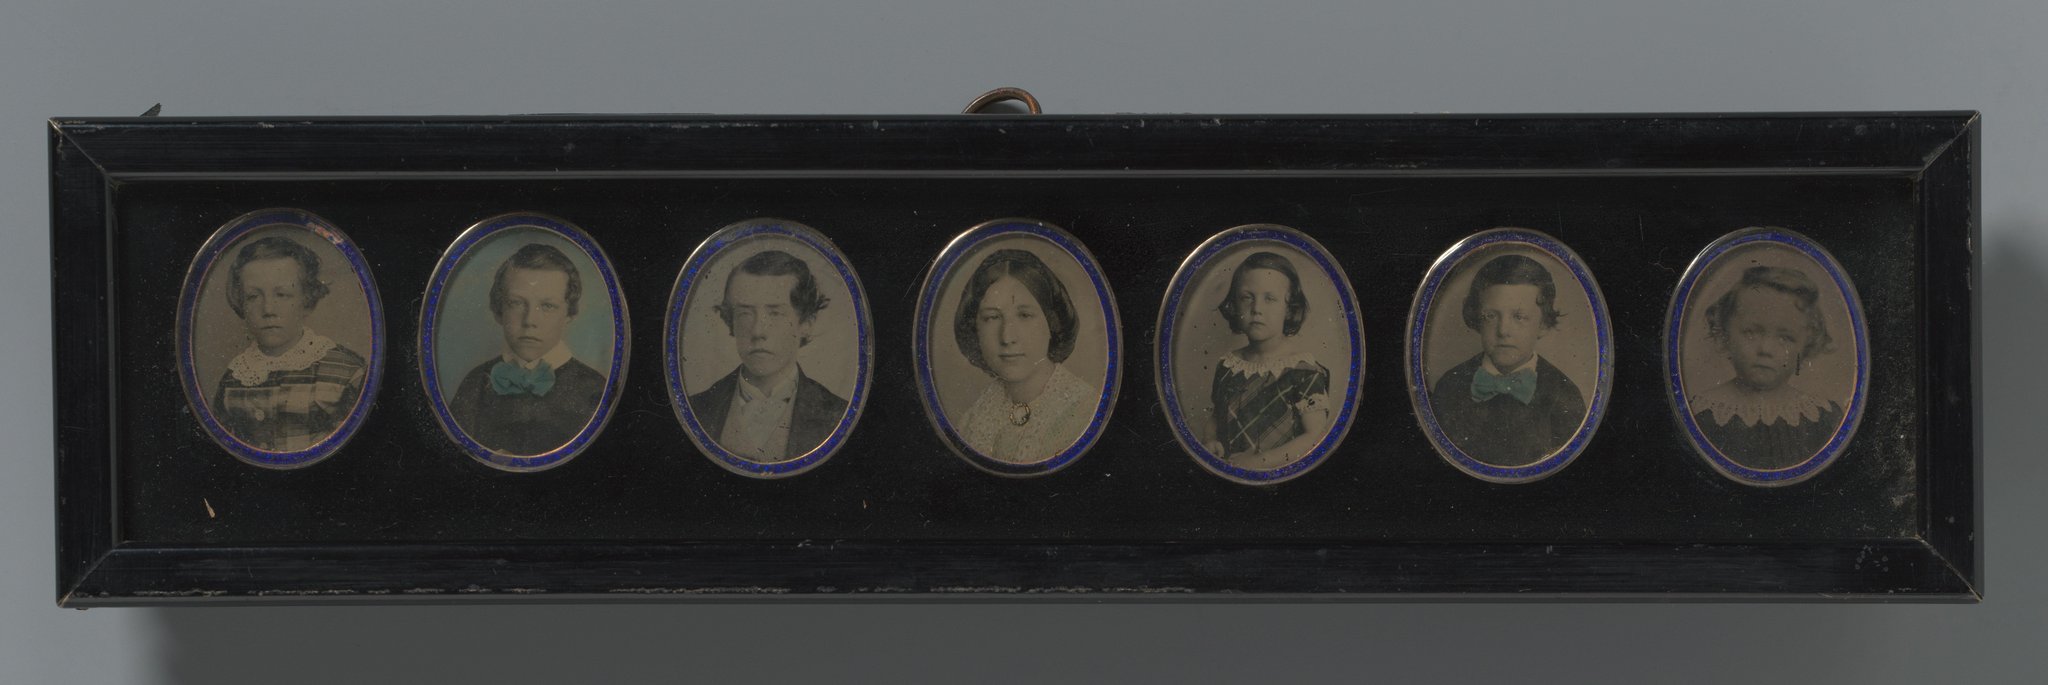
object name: photograph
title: Zeven portretten van onbekende kinderen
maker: Anonymous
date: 1855-1870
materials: glass, metal, paper, wood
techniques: ambrotype, hand coloring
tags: child, historical persons not known by name